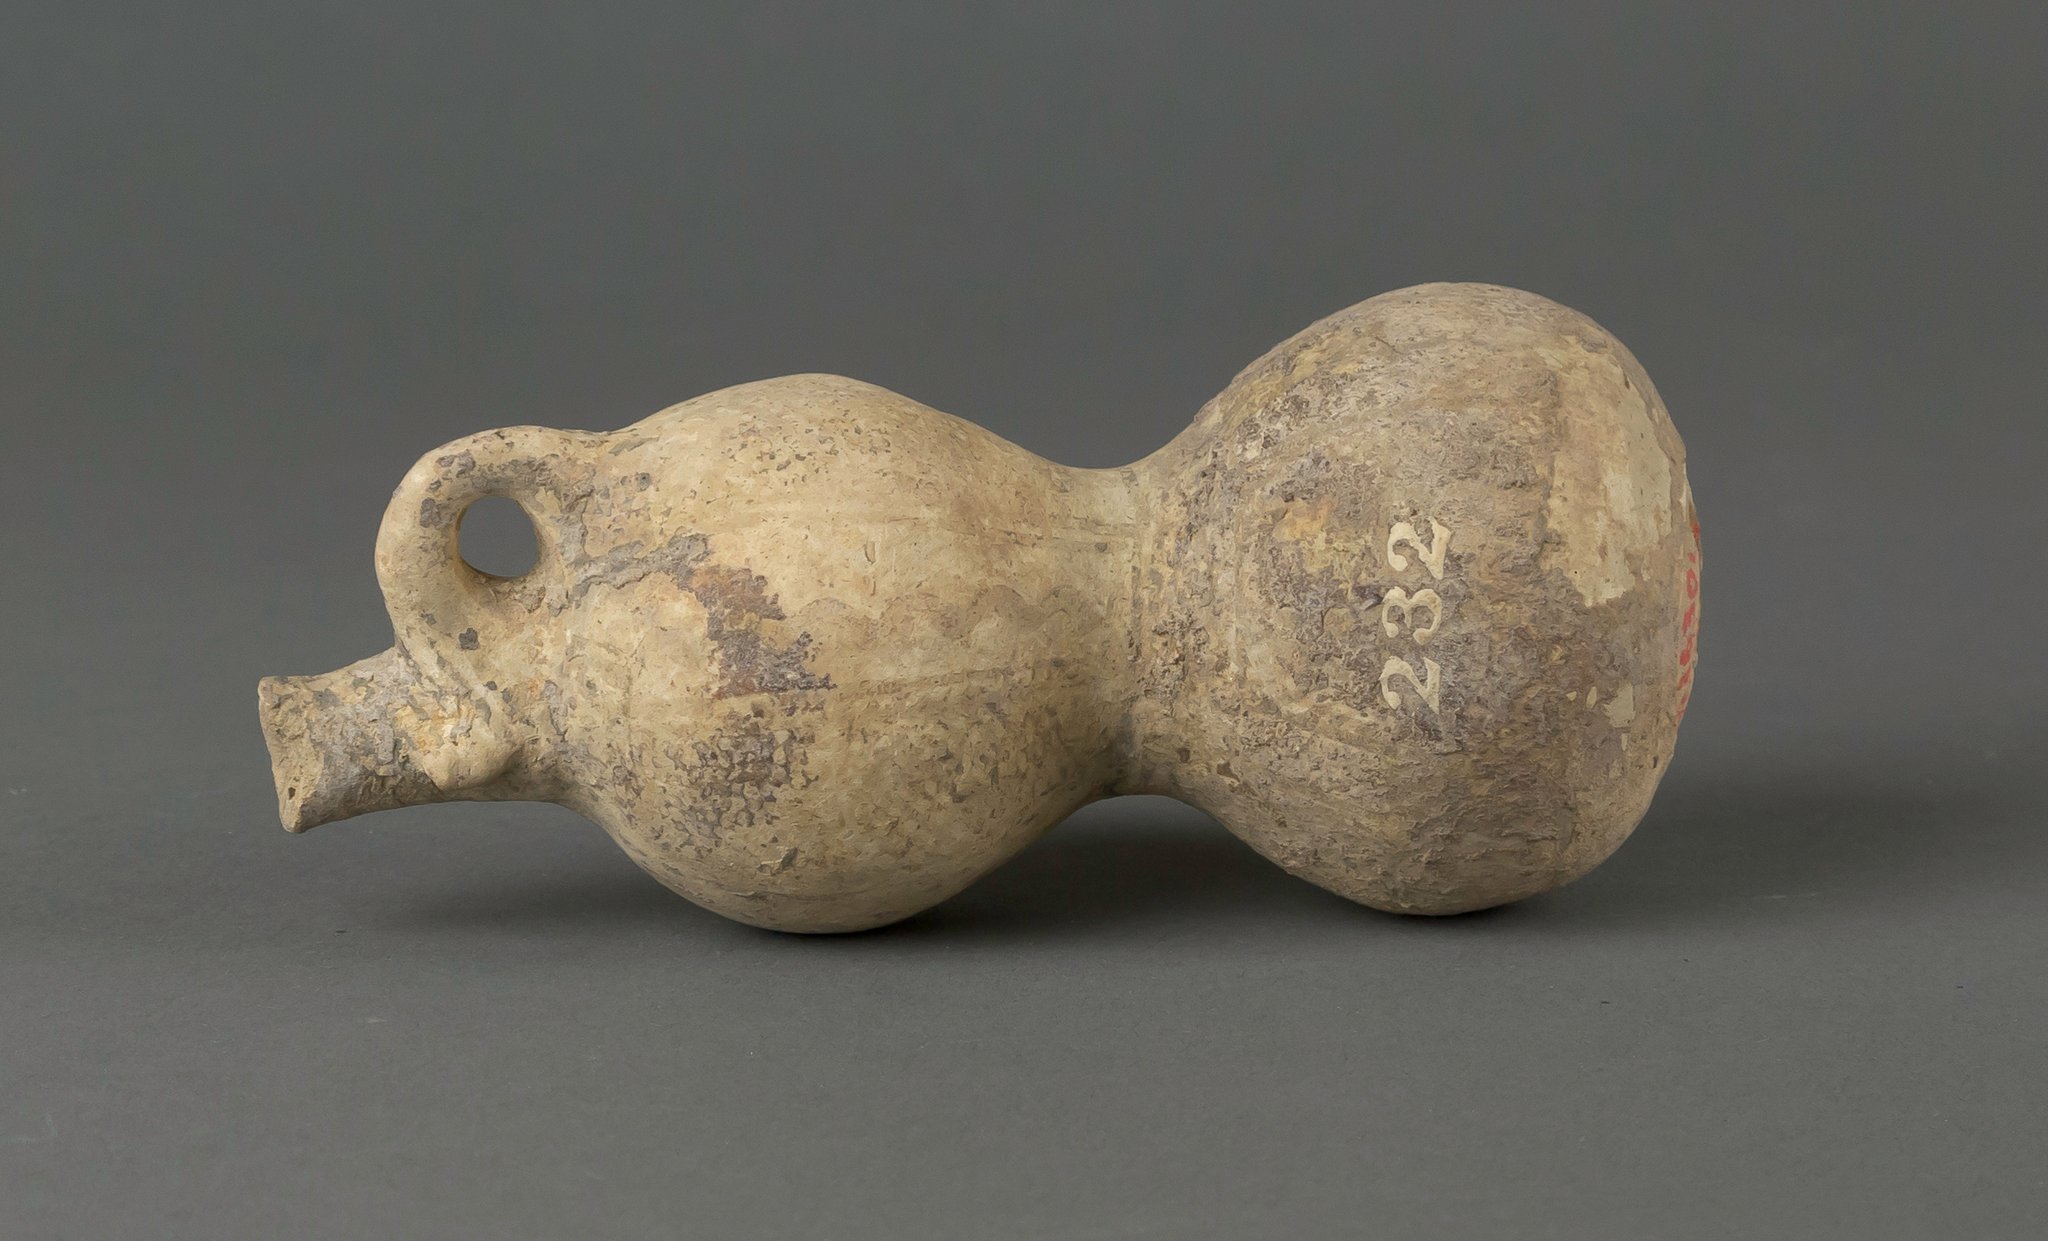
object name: vase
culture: cypriot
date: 1900-1600 BCE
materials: terracotta